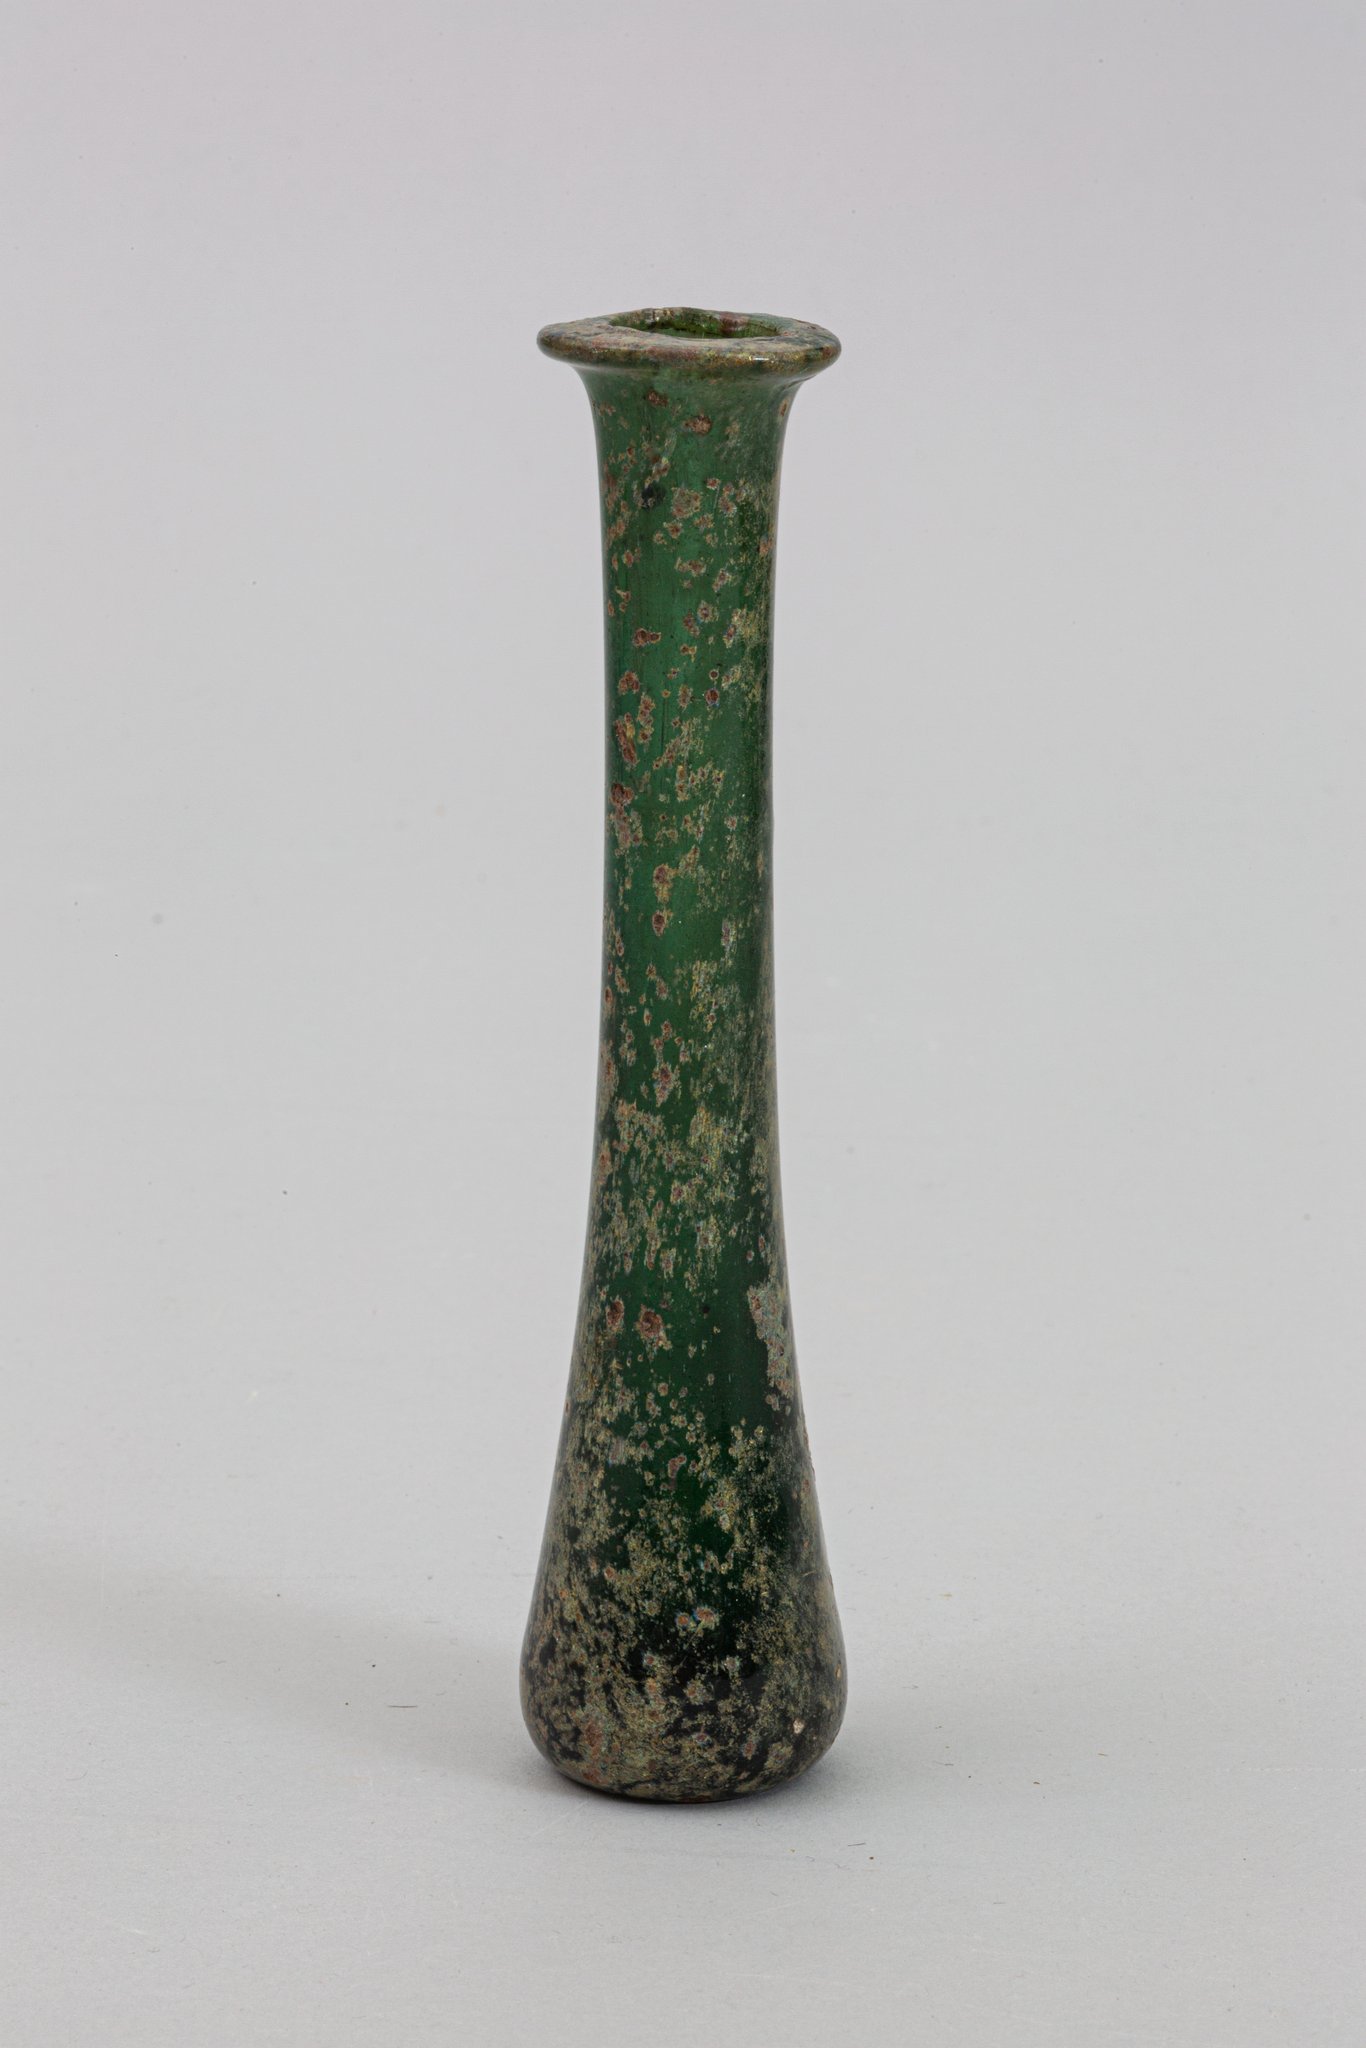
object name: perfume bottle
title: Glass perfume bottle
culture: roman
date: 67-400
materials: glass